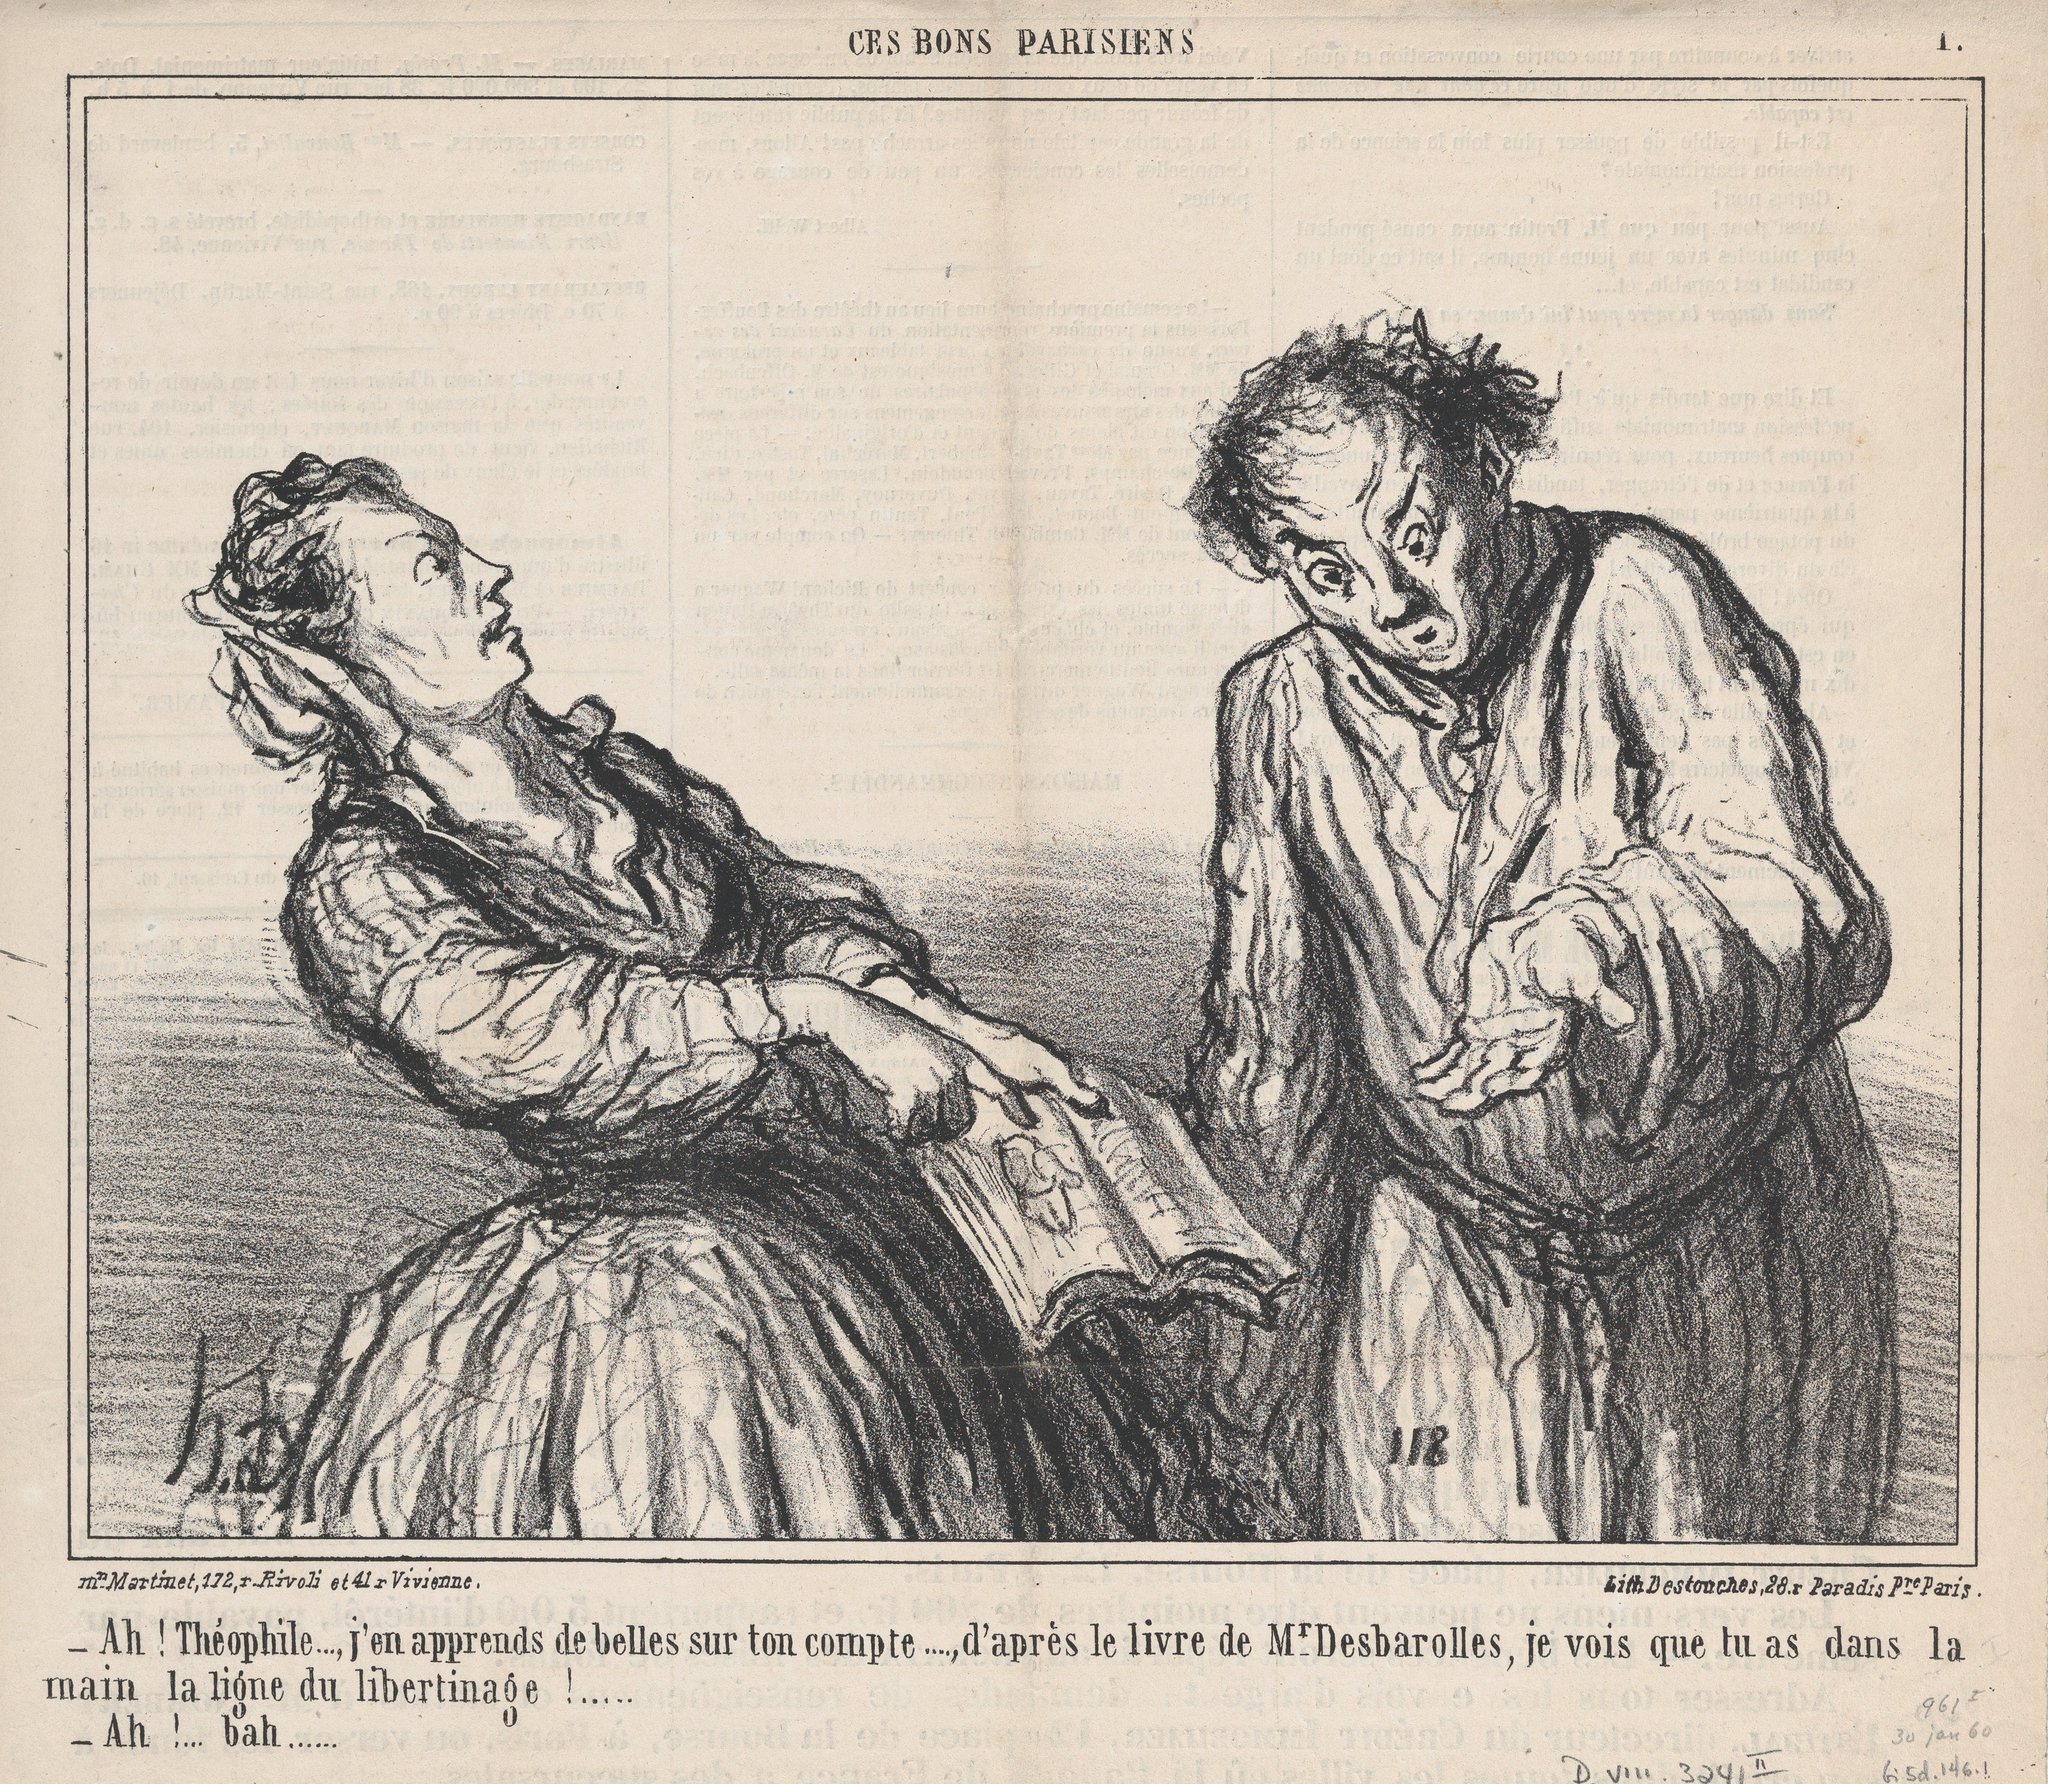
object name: print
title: Ah, Théophile, what ghastly things I am reading about you, from 'These good Parisians,' published in Le Charivari, January 30, 1860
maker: honoré daumier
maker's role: artist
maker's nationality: french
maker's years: 1808-1879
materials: paper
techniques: lithograph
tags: men,women